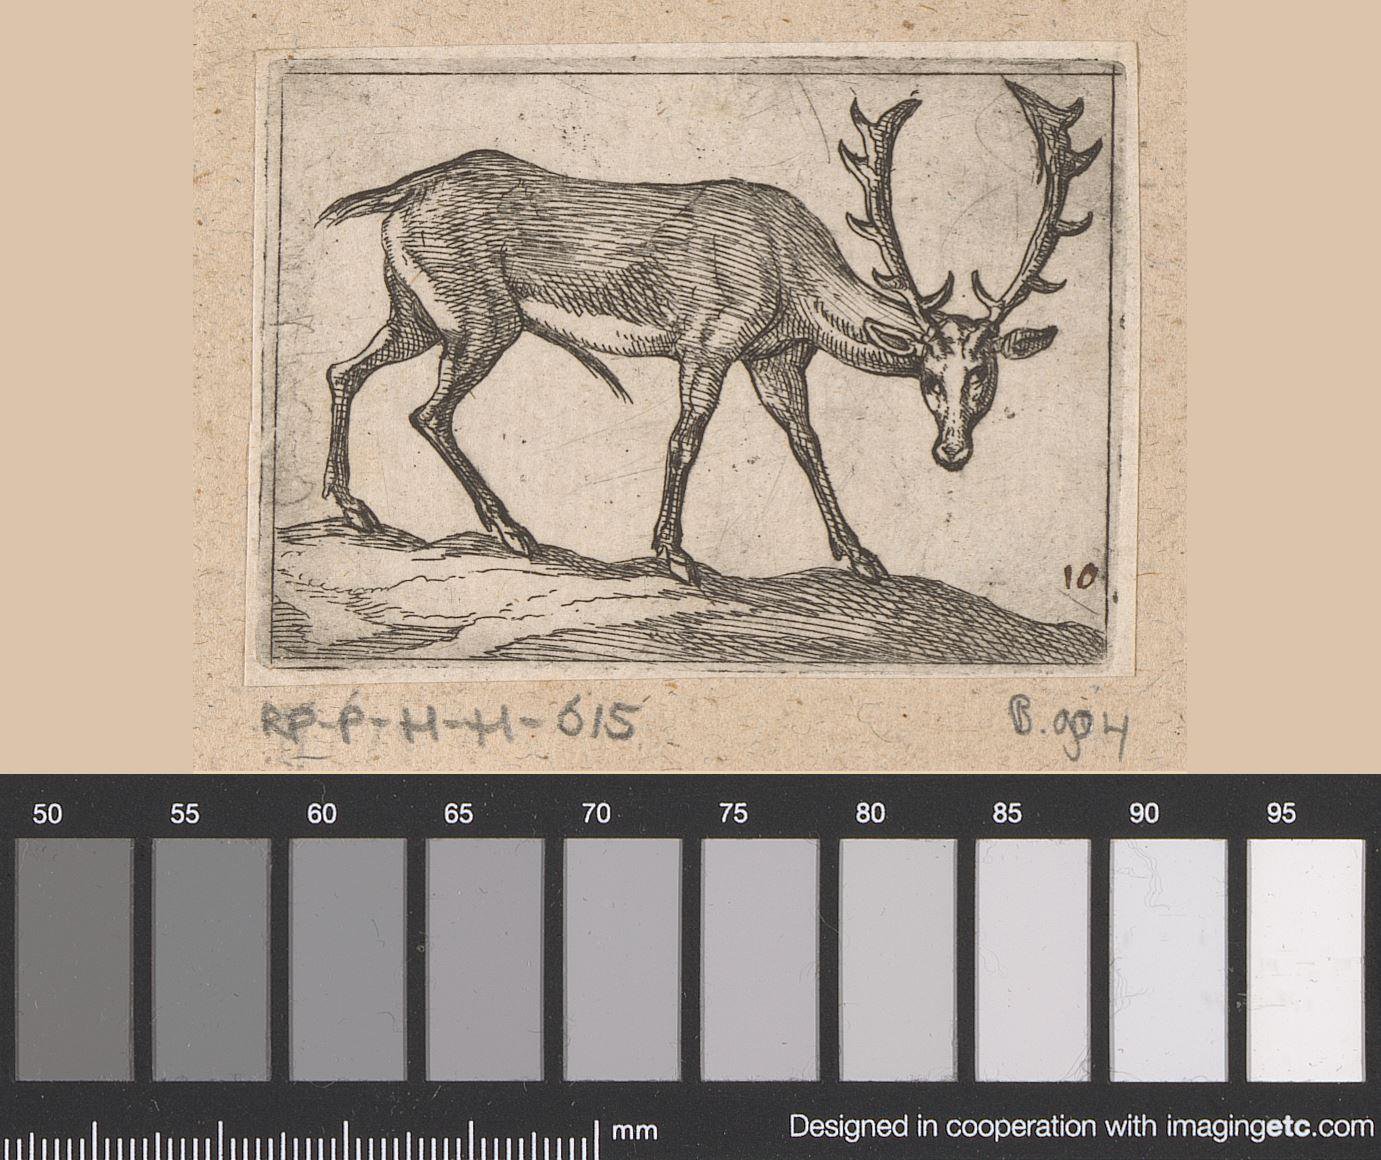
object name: print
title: Verschillende dieren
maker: antonio tempesta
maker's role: draughtsman, painter, print maker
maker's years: 1555-1630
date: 1565-1630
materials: paper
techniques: etching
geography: italy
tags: hoofed animals: stag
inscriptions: number: ‘10’, collector's mark: Lugt 11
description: Deze prent maakt deel uit van een reeks van 28 prenten van dieren.